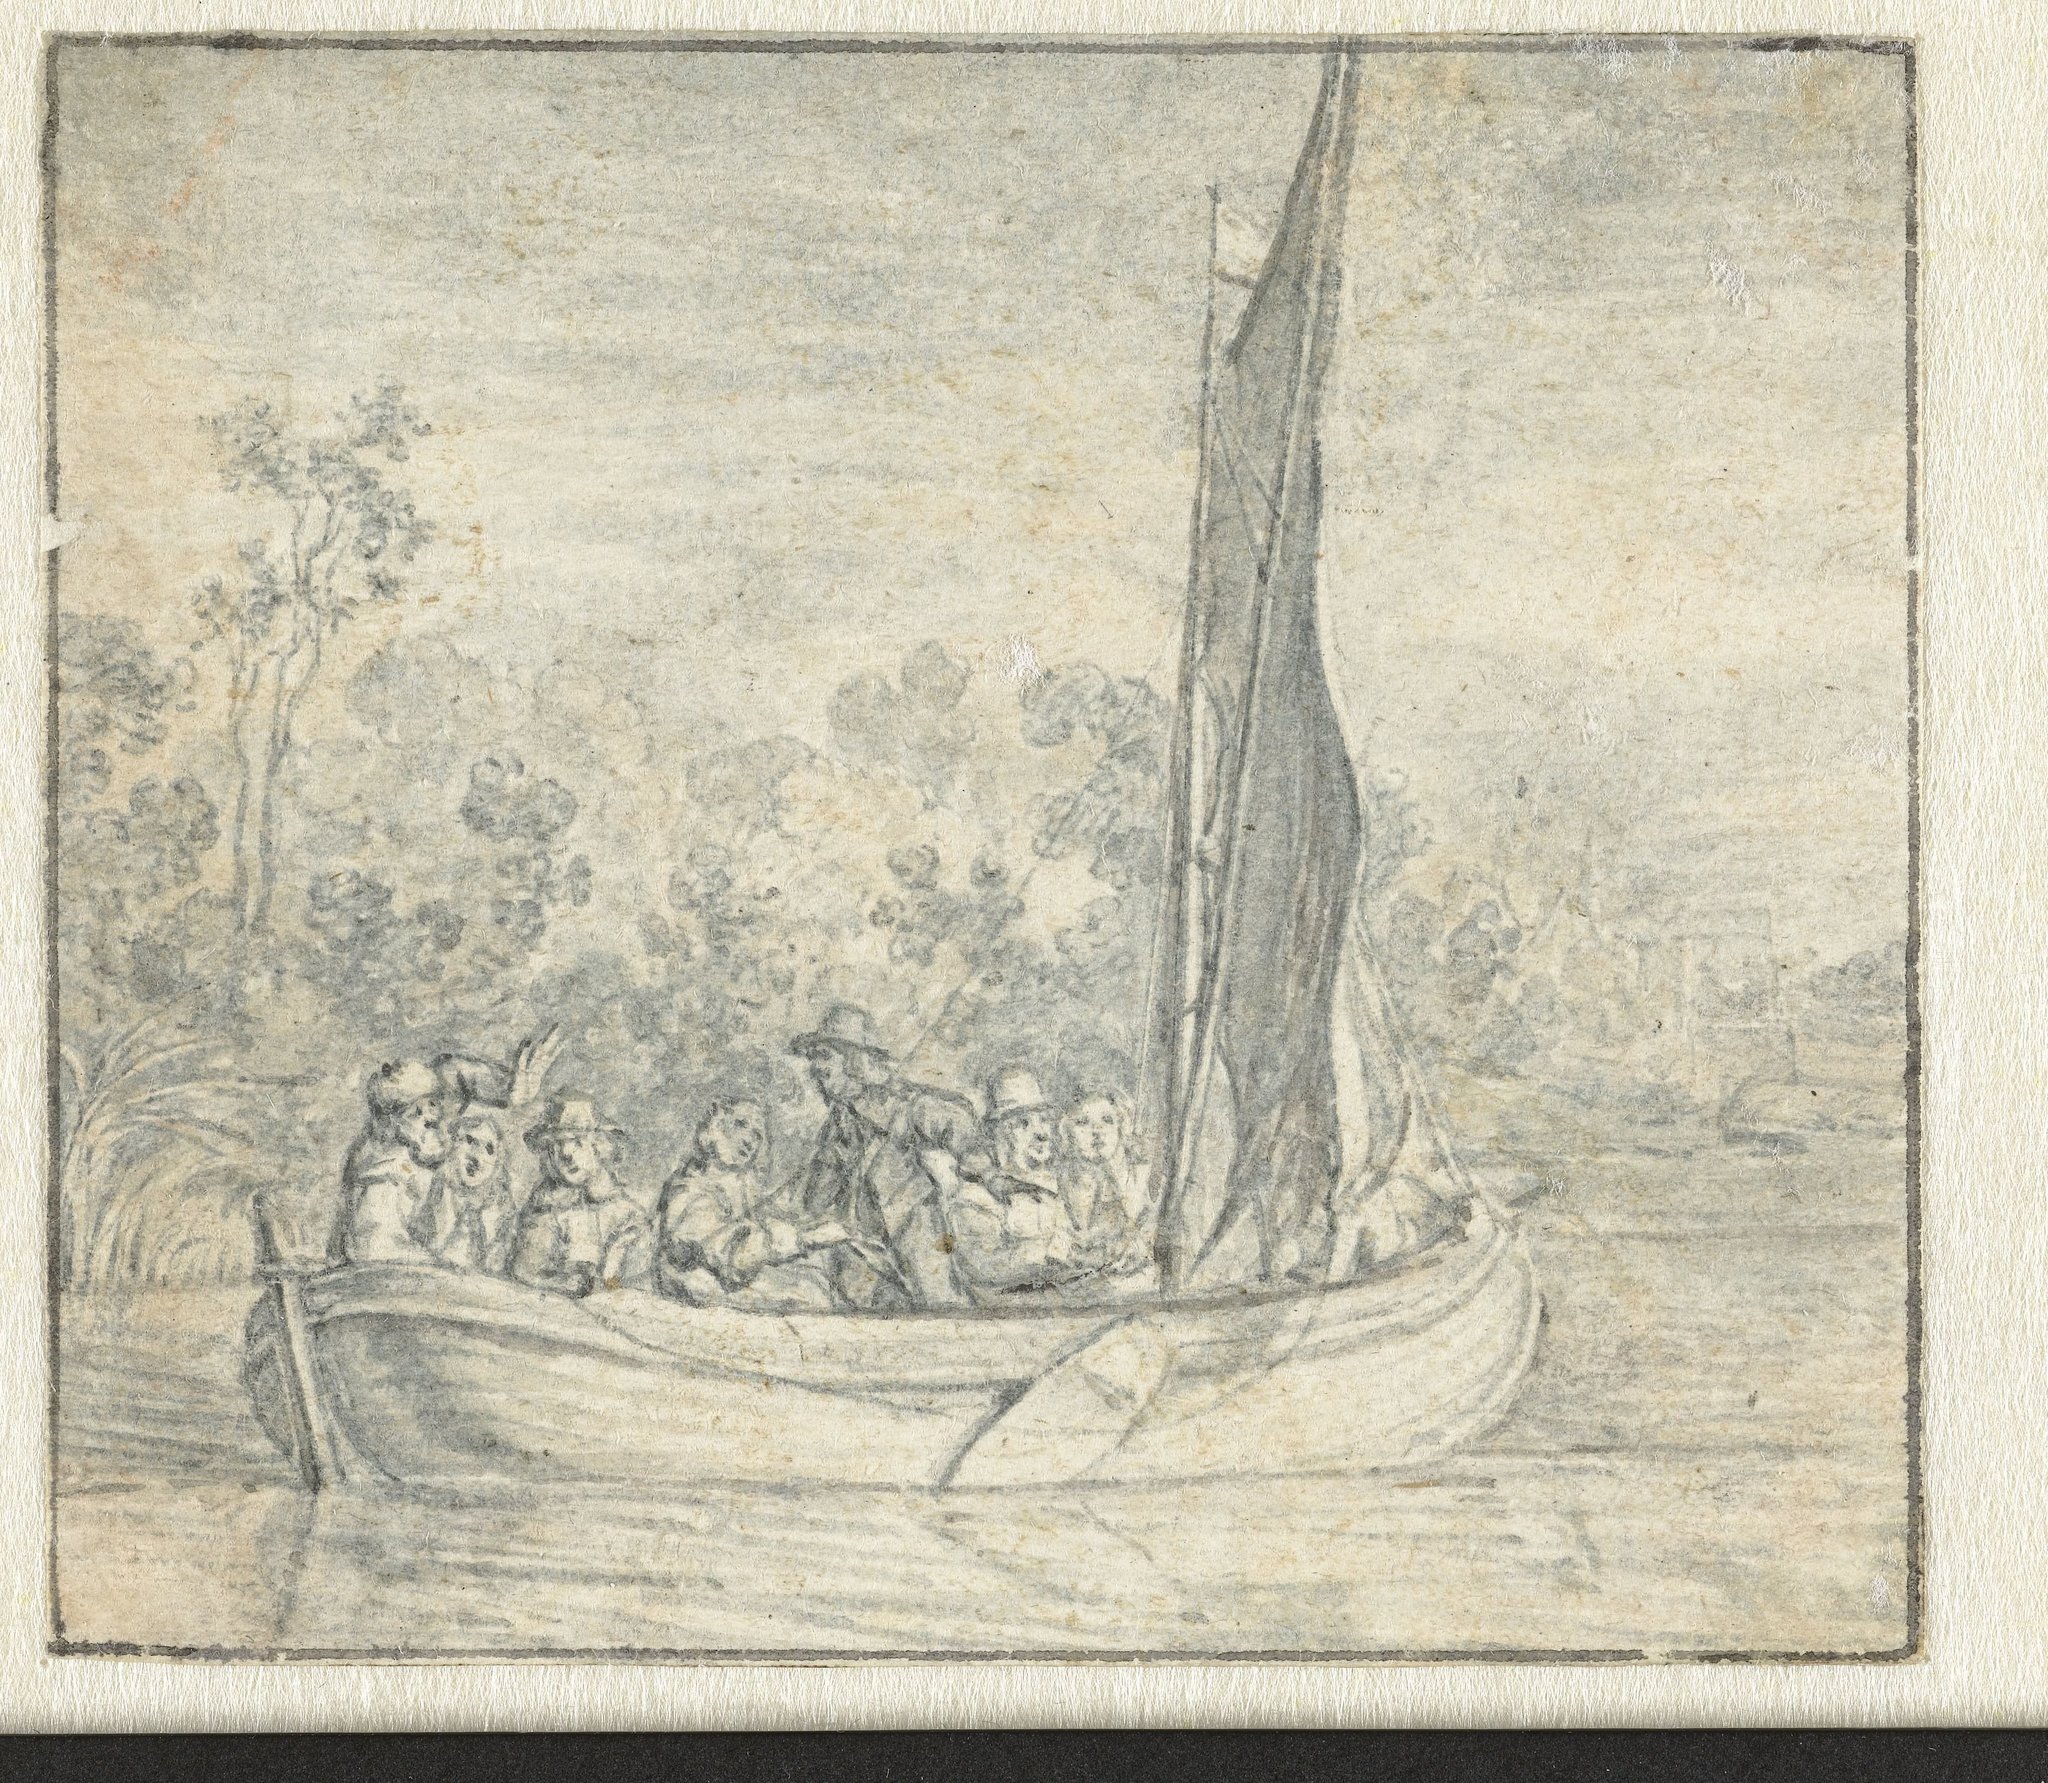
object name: design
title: Gezelschap in een zeilbootje op een rivier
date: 1616-1660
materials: ink, paper, pencil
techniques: brush, pen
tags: sailing-ship, sailing-boat, river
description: Gezelschap van mannen en vrouwen in een zeilbootje op een rivier. Mogelijk een ontwerp voor een prent.